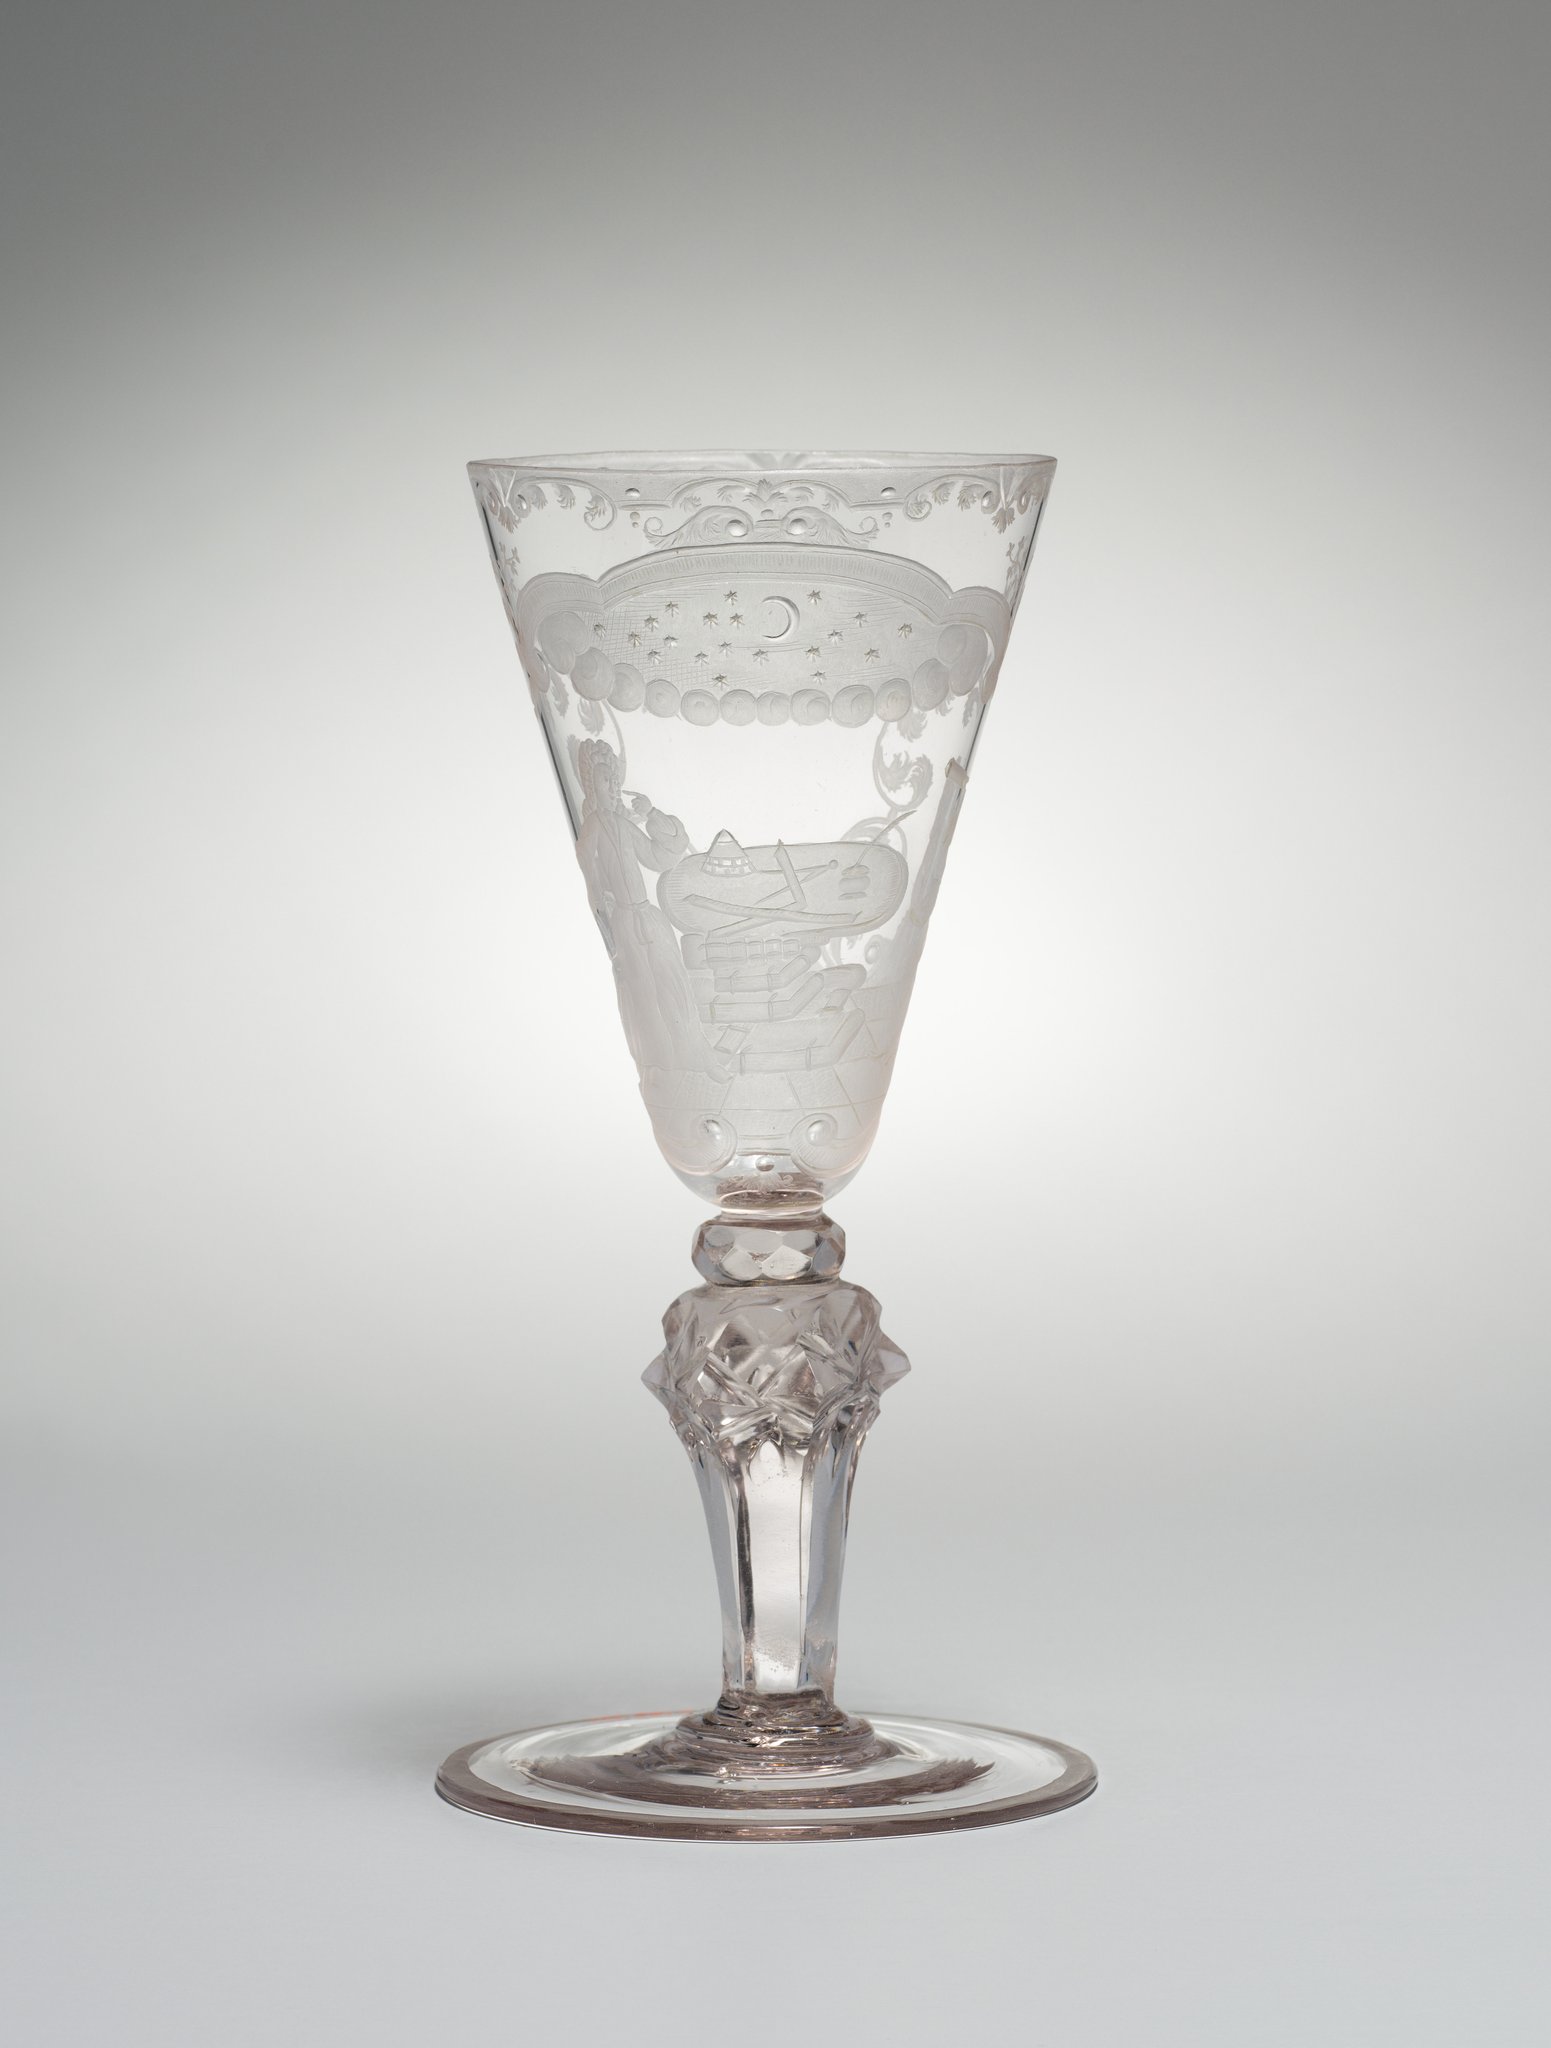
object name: wineglass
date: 1730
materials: glass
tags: men,telescopes